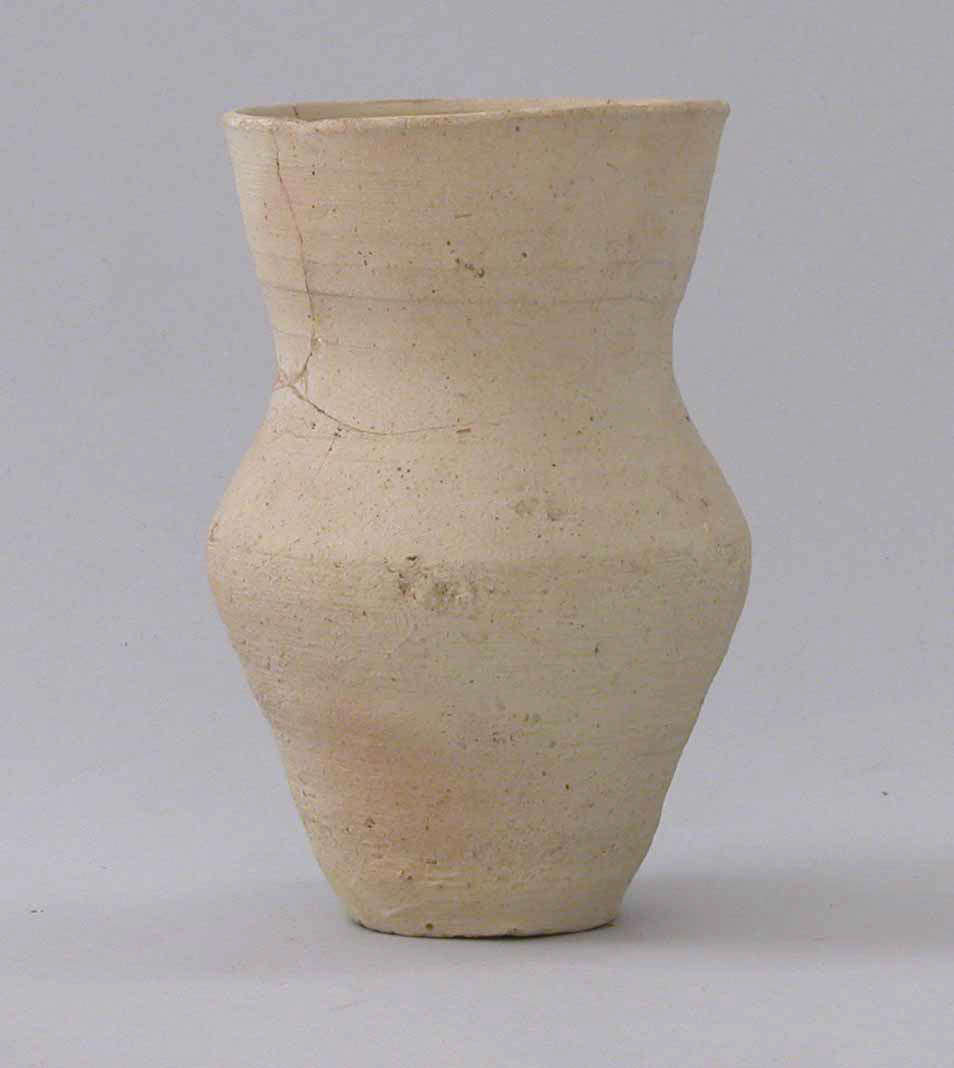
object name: jar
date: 801-900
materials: earthenware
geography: iran